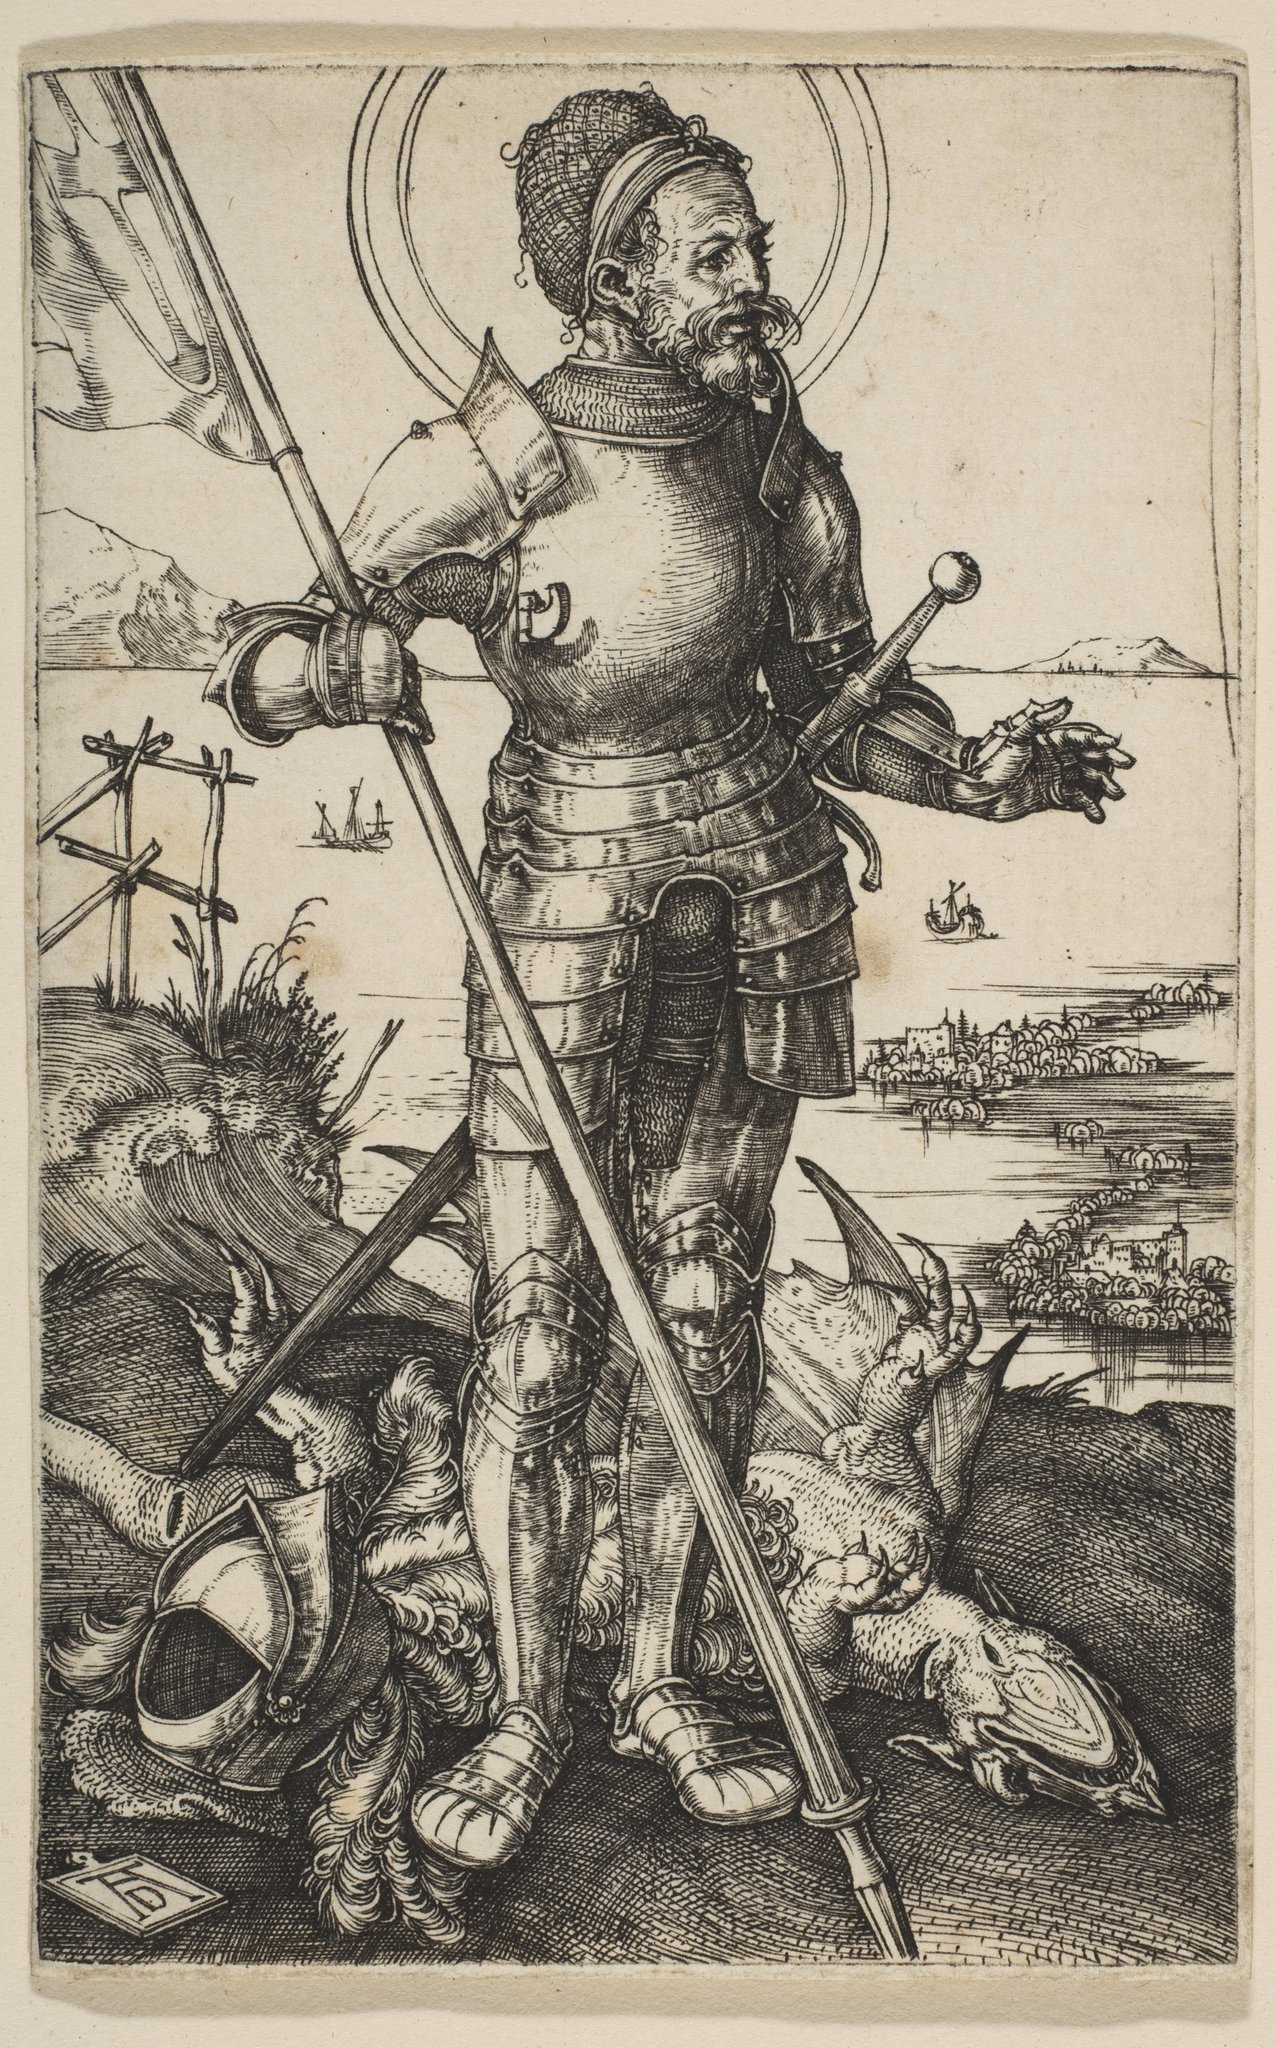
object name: print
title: Saint George Standing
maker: albrecht dürer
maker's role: artist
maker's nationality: german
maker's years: 1471-1528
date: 1502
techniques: engraving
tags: saint george